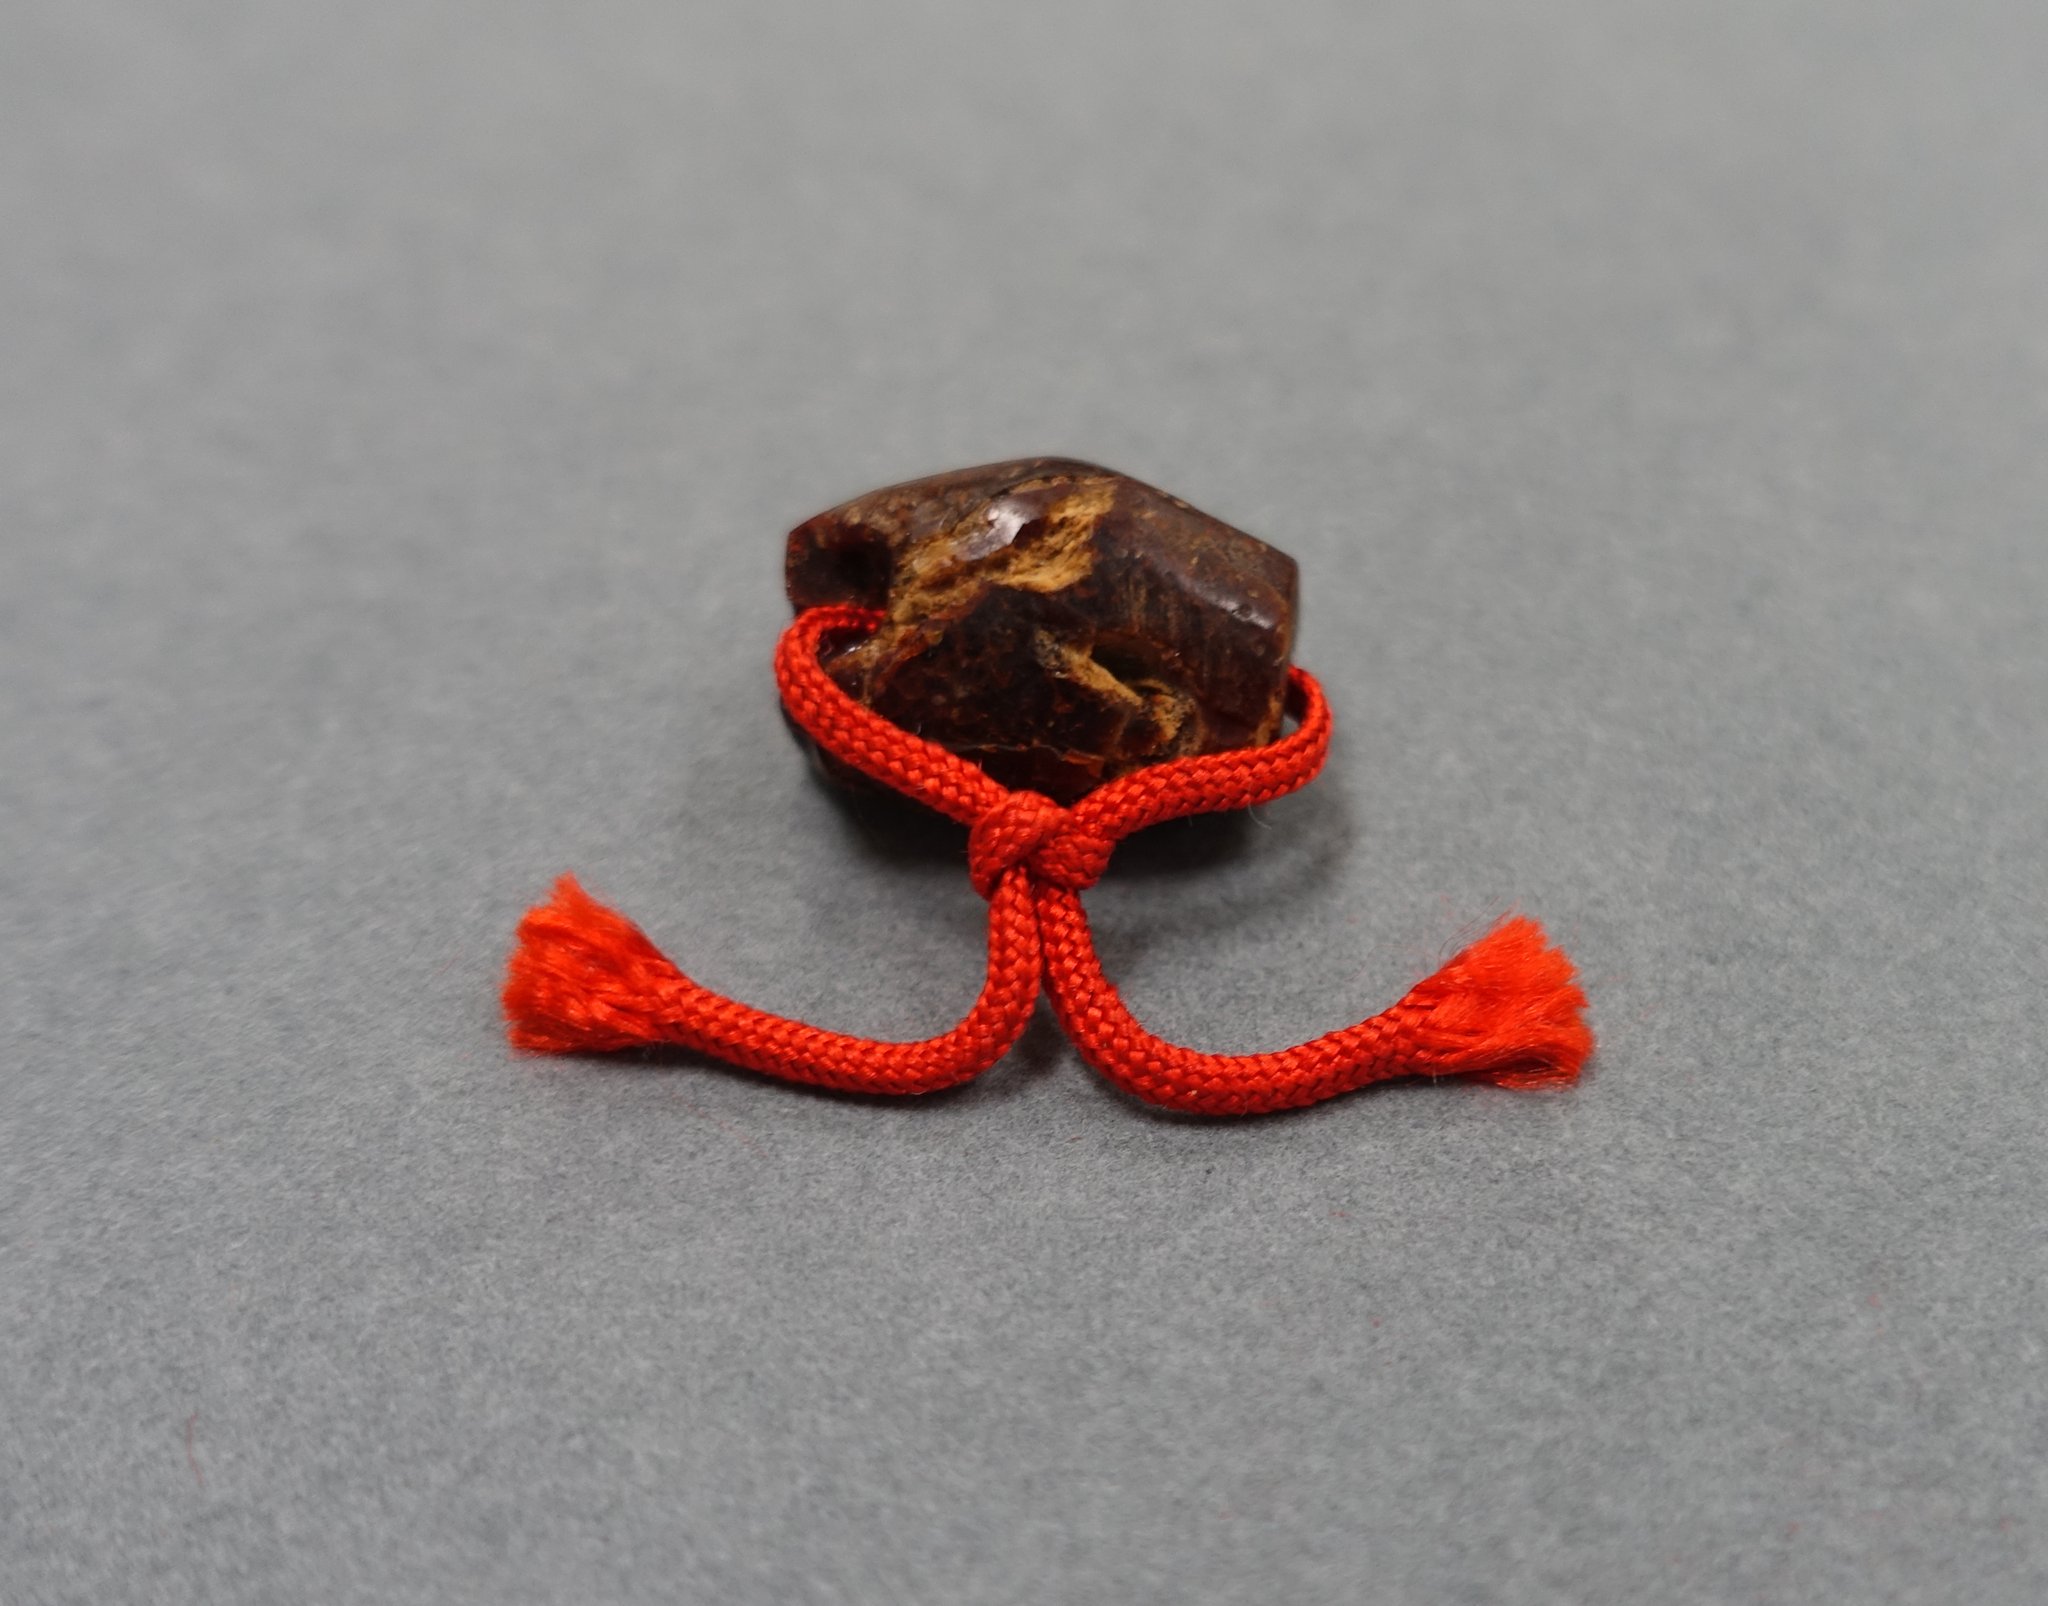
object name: cylinder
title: Inscribed Cylinder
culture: japanese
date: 601-700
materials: amber